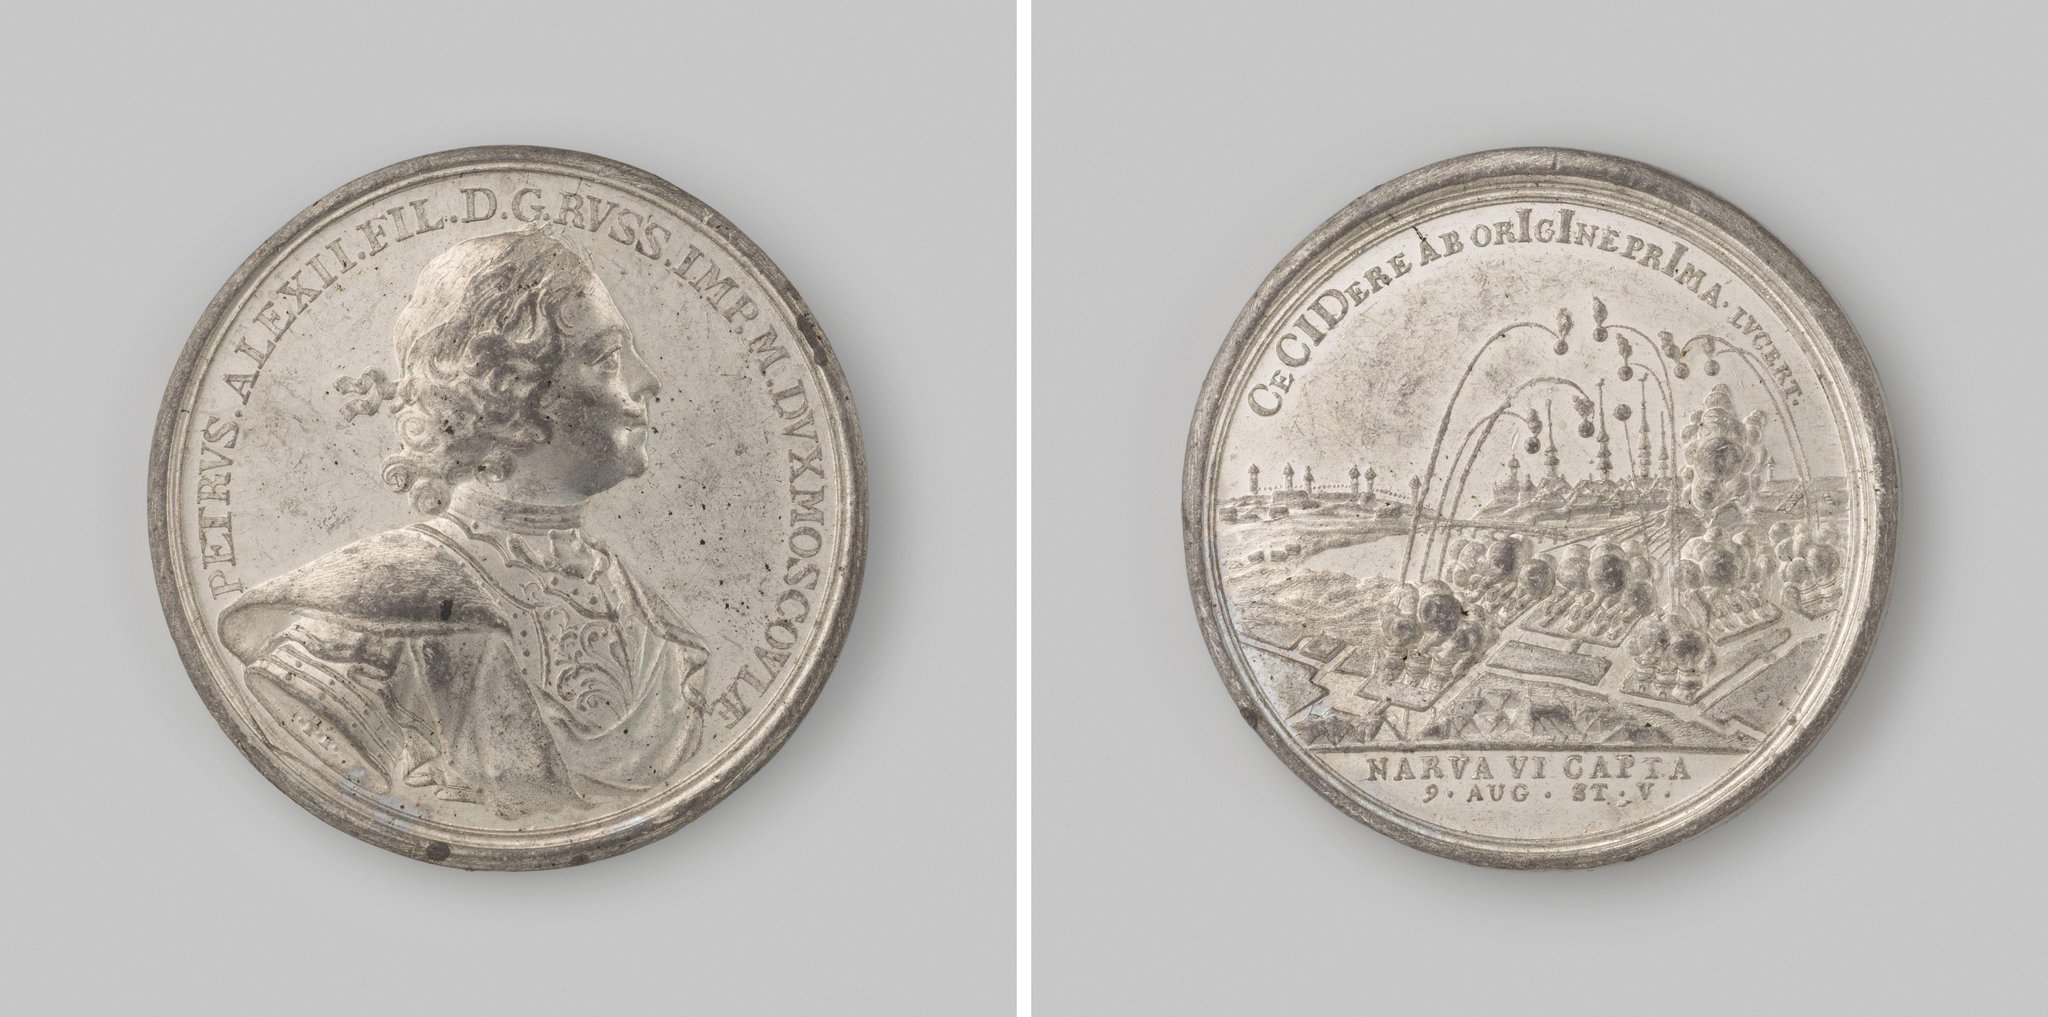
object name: history medal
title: Inname van Narva door Rusland op Zweden 1704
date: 1704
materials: tin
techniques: striking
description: Tinnen penning, op de voorzijde het borstbeeld van Tsaar Peter de Grote naar rechts met omschrift, op de keerzijde het bombardement van Narca met omschrift en afsnedetekst.